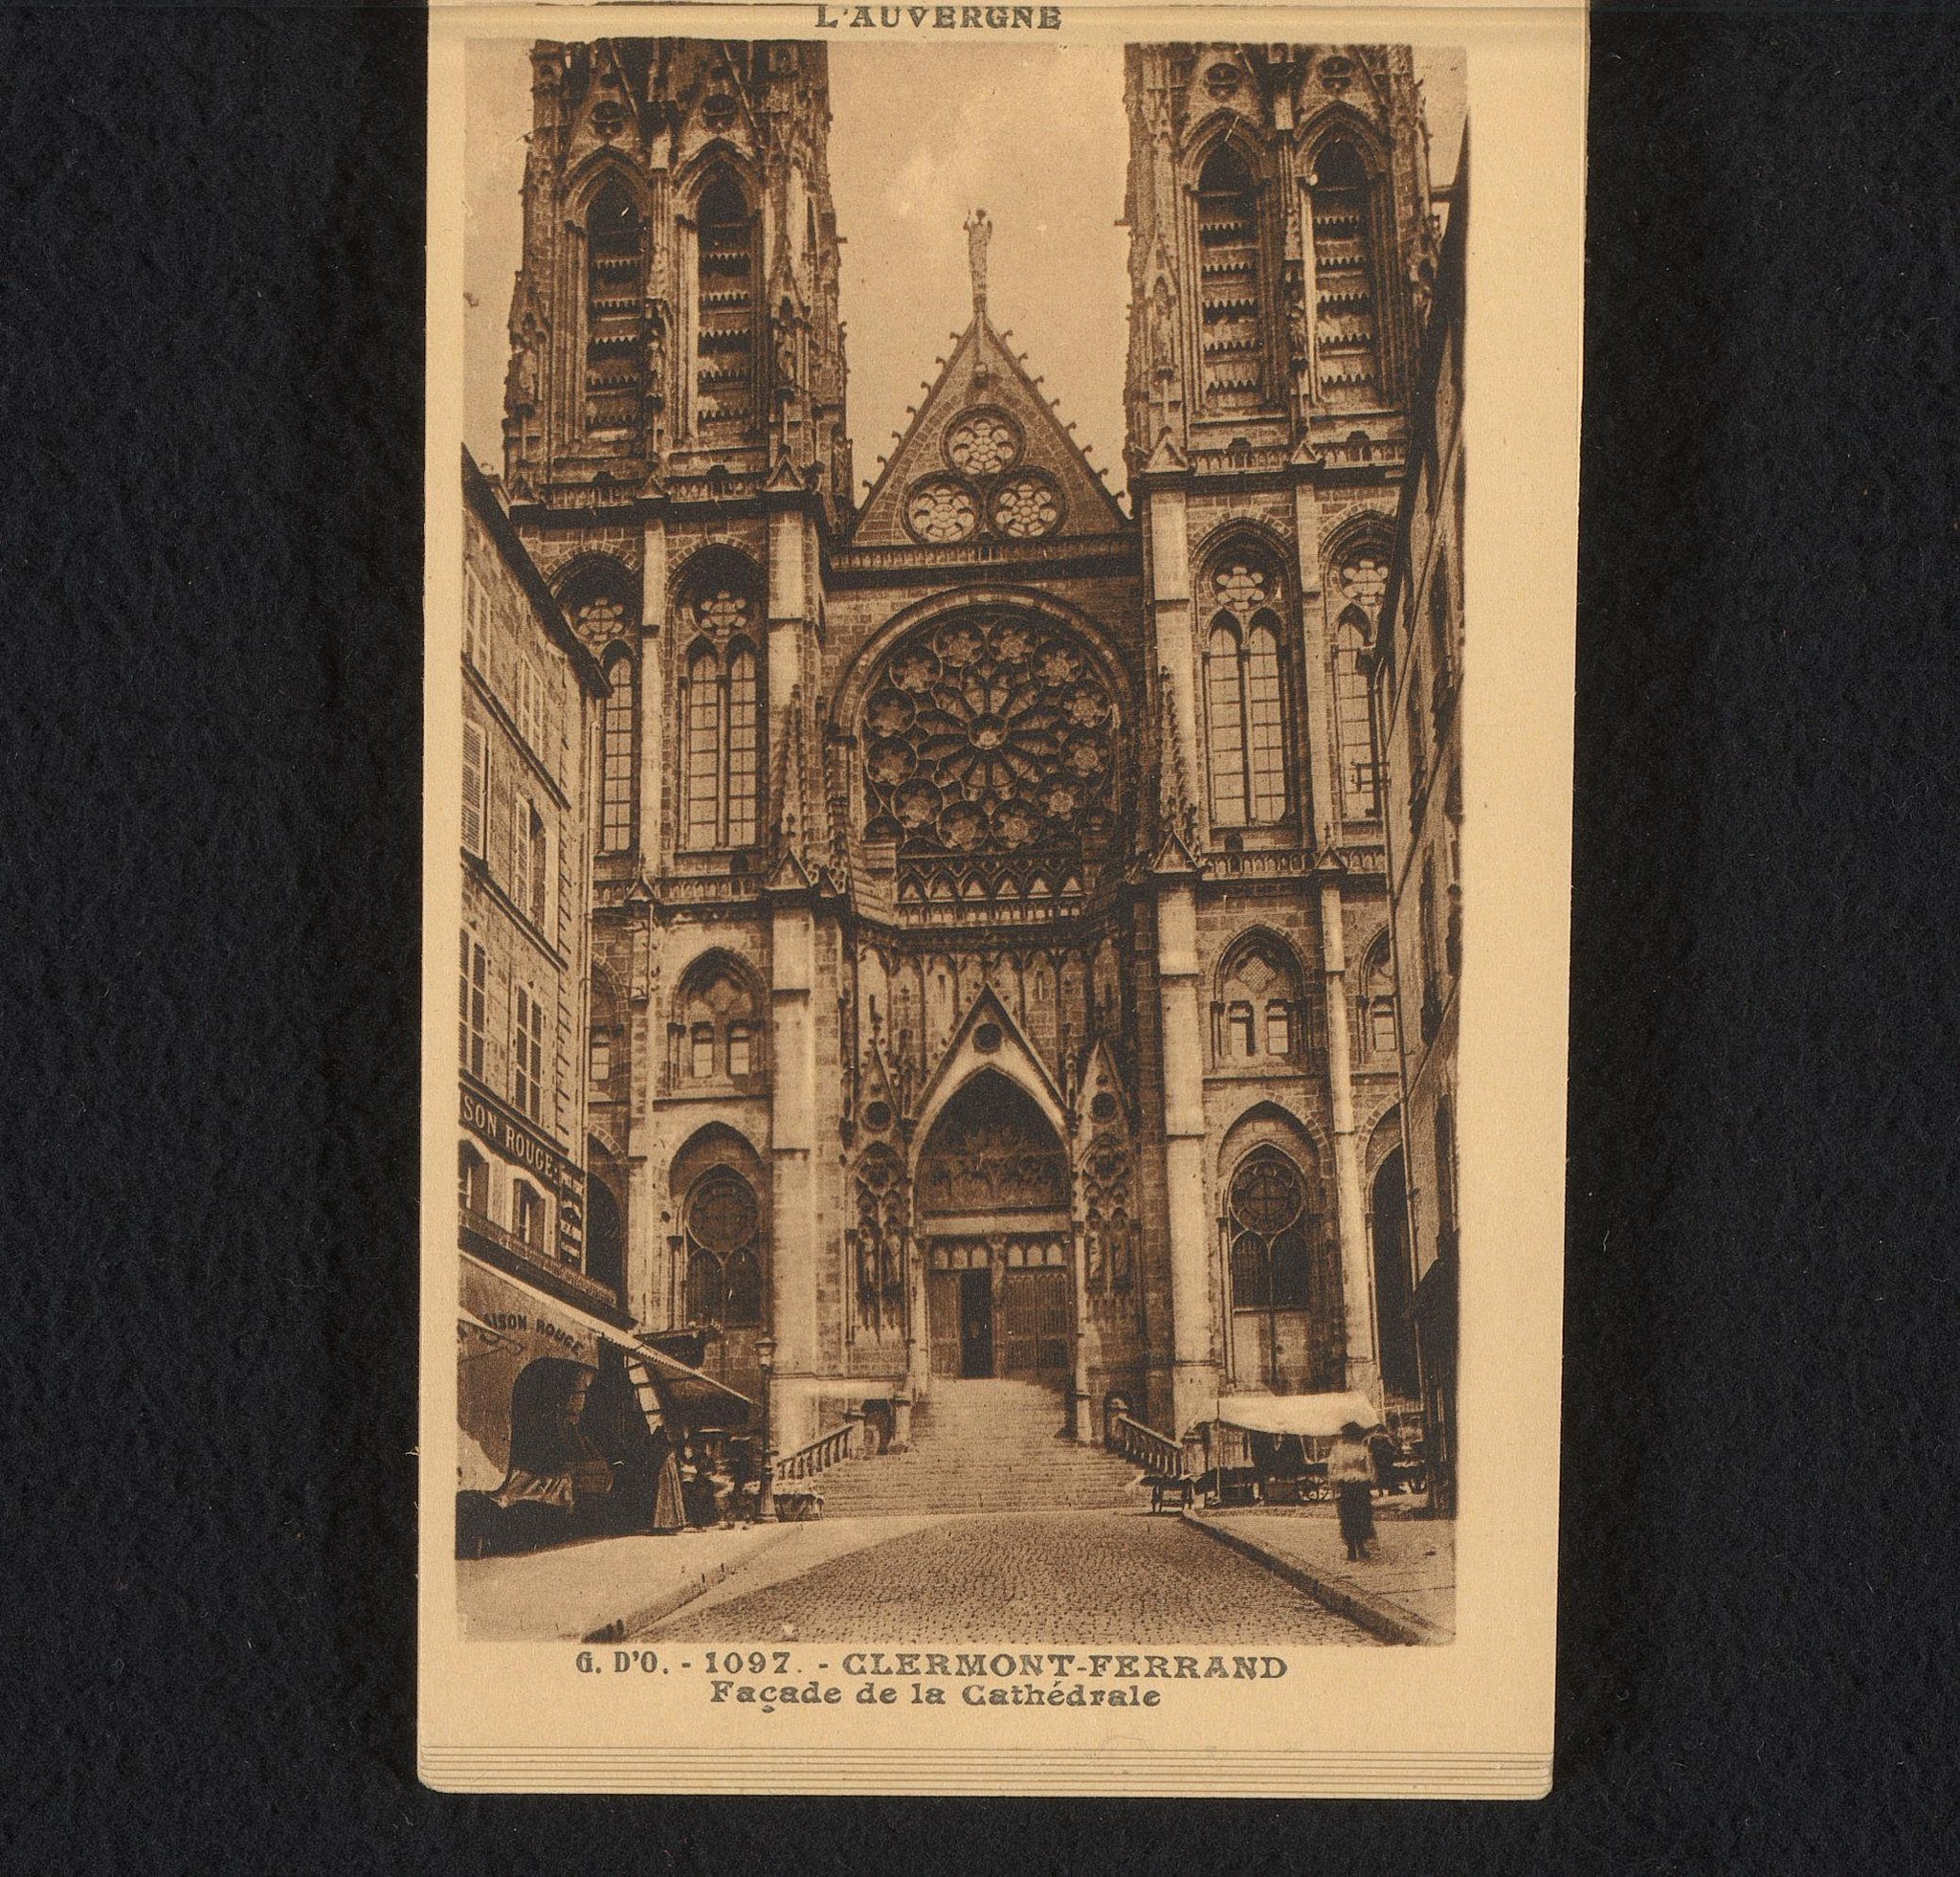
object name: ansichtkaart, prentbriefkaart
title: L'Auvergne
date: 1921-1930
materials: cardboard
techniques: photograph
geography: olliergues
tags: city-view, and landscape with man-made constructions, church (exterior)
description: Prentbriefkaart maakt deel uit van een album.